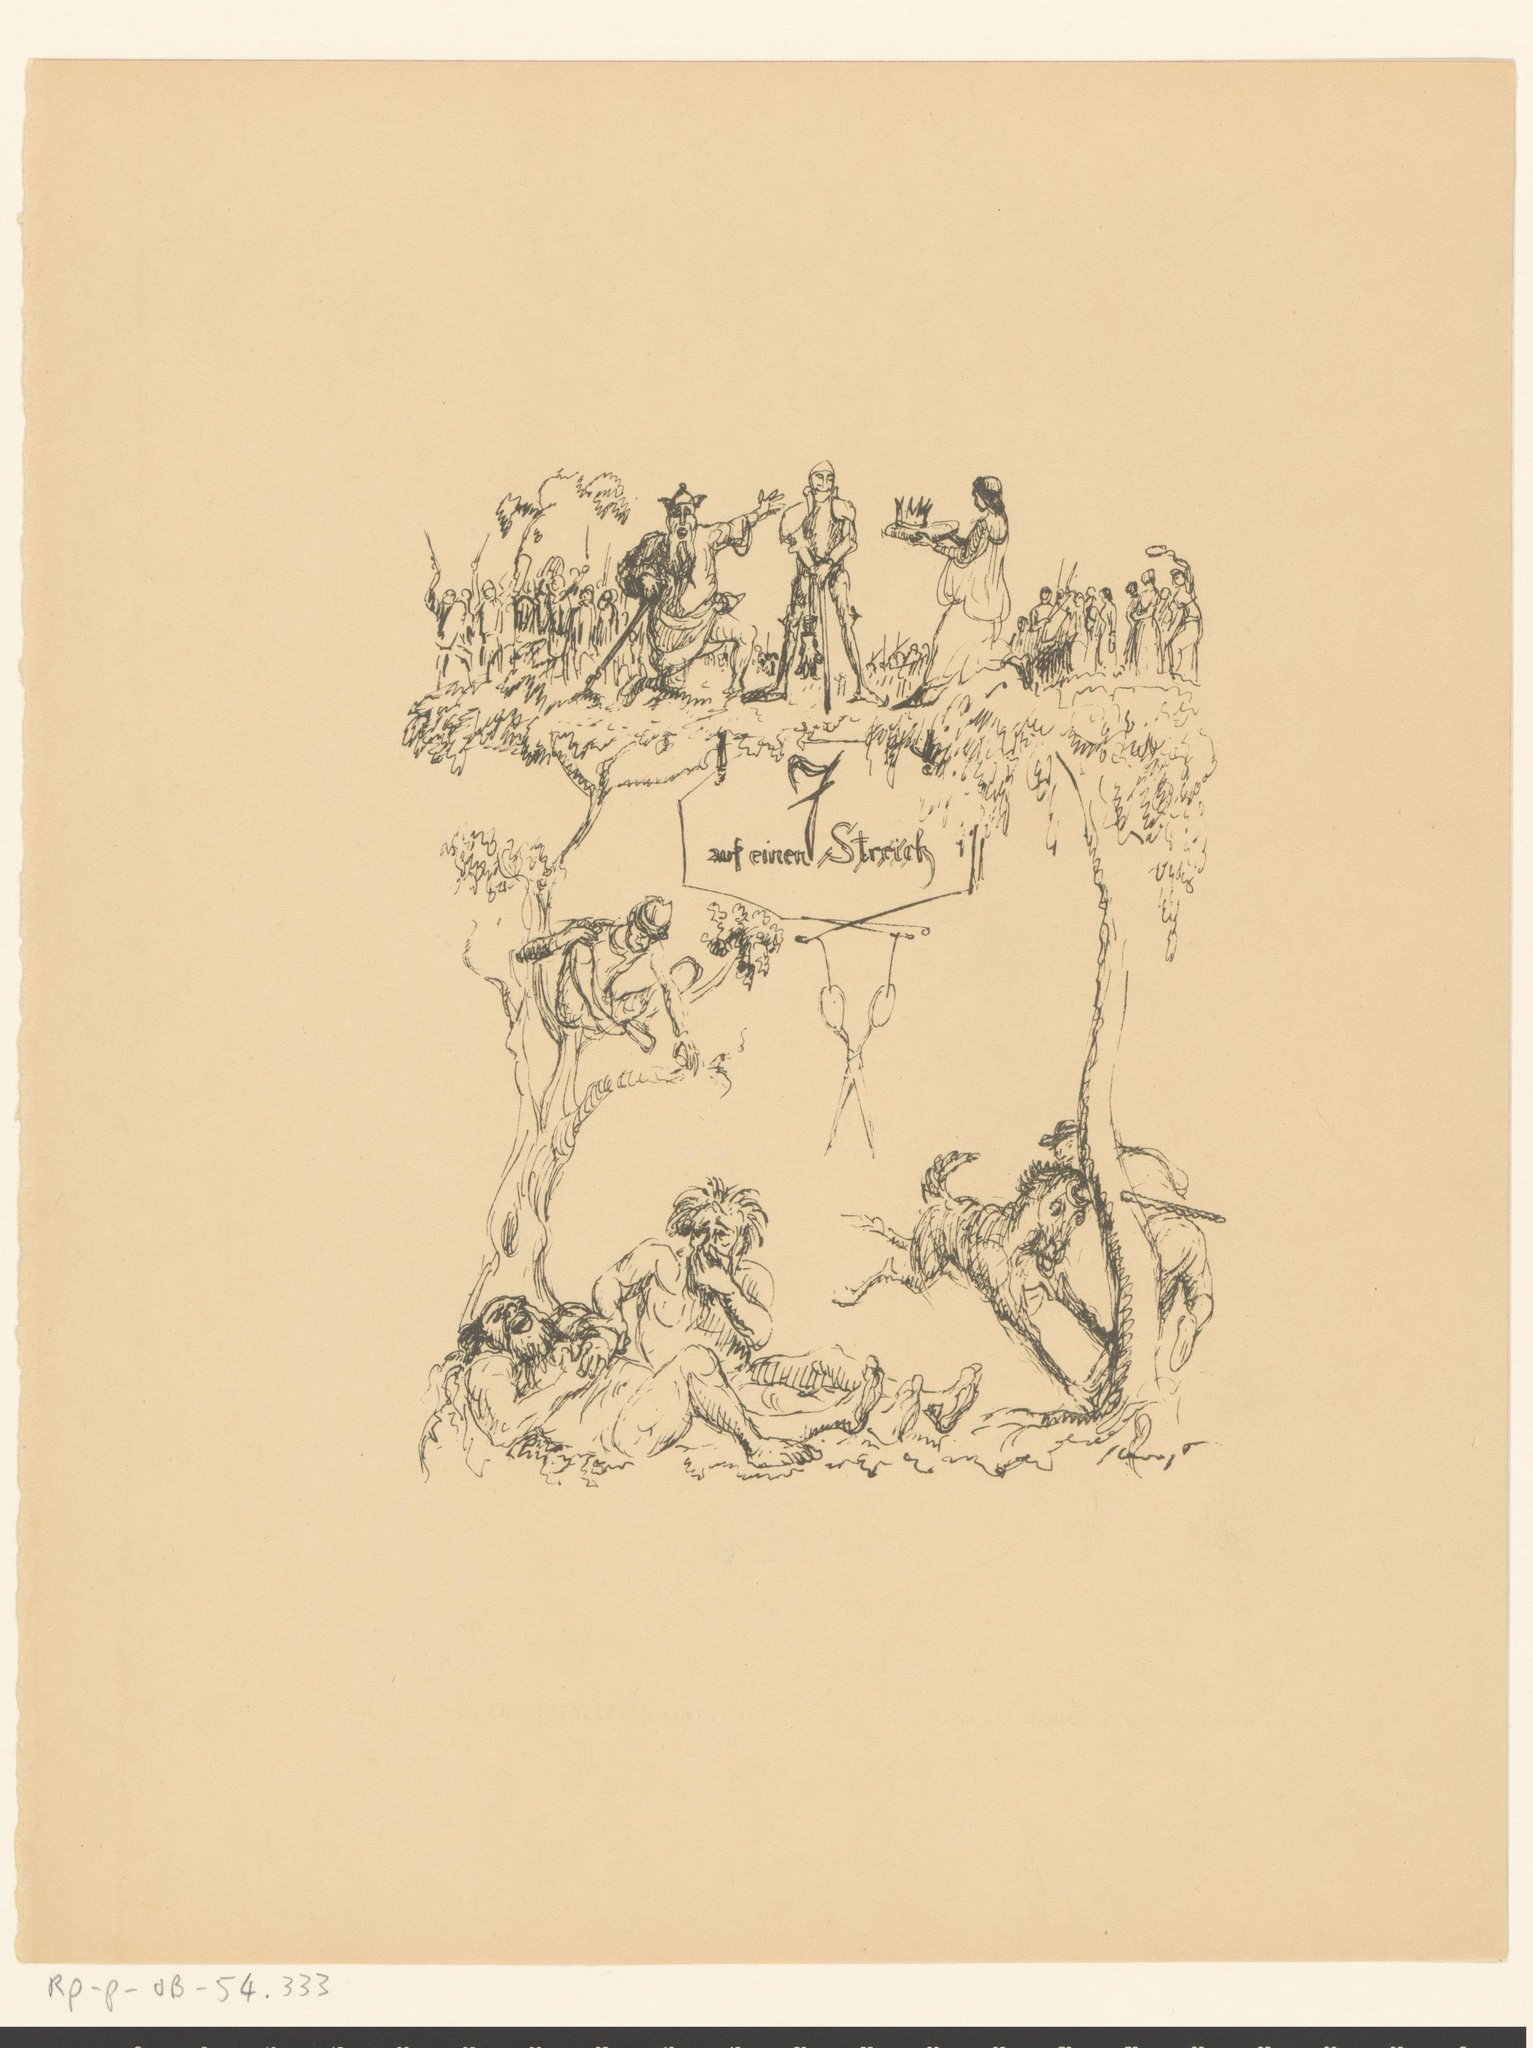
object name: print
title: 7 auf einen Streich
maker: max slevogt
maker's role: print maker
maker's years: 1868-1932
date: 1878-1932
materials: paper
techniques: lithograph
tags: tales and fairy tales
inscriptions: collector's mark: Lugt 2228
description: Afbeelding van een passage uit het sprookje Het dappere snijdertje van de gebroeders Grimm.